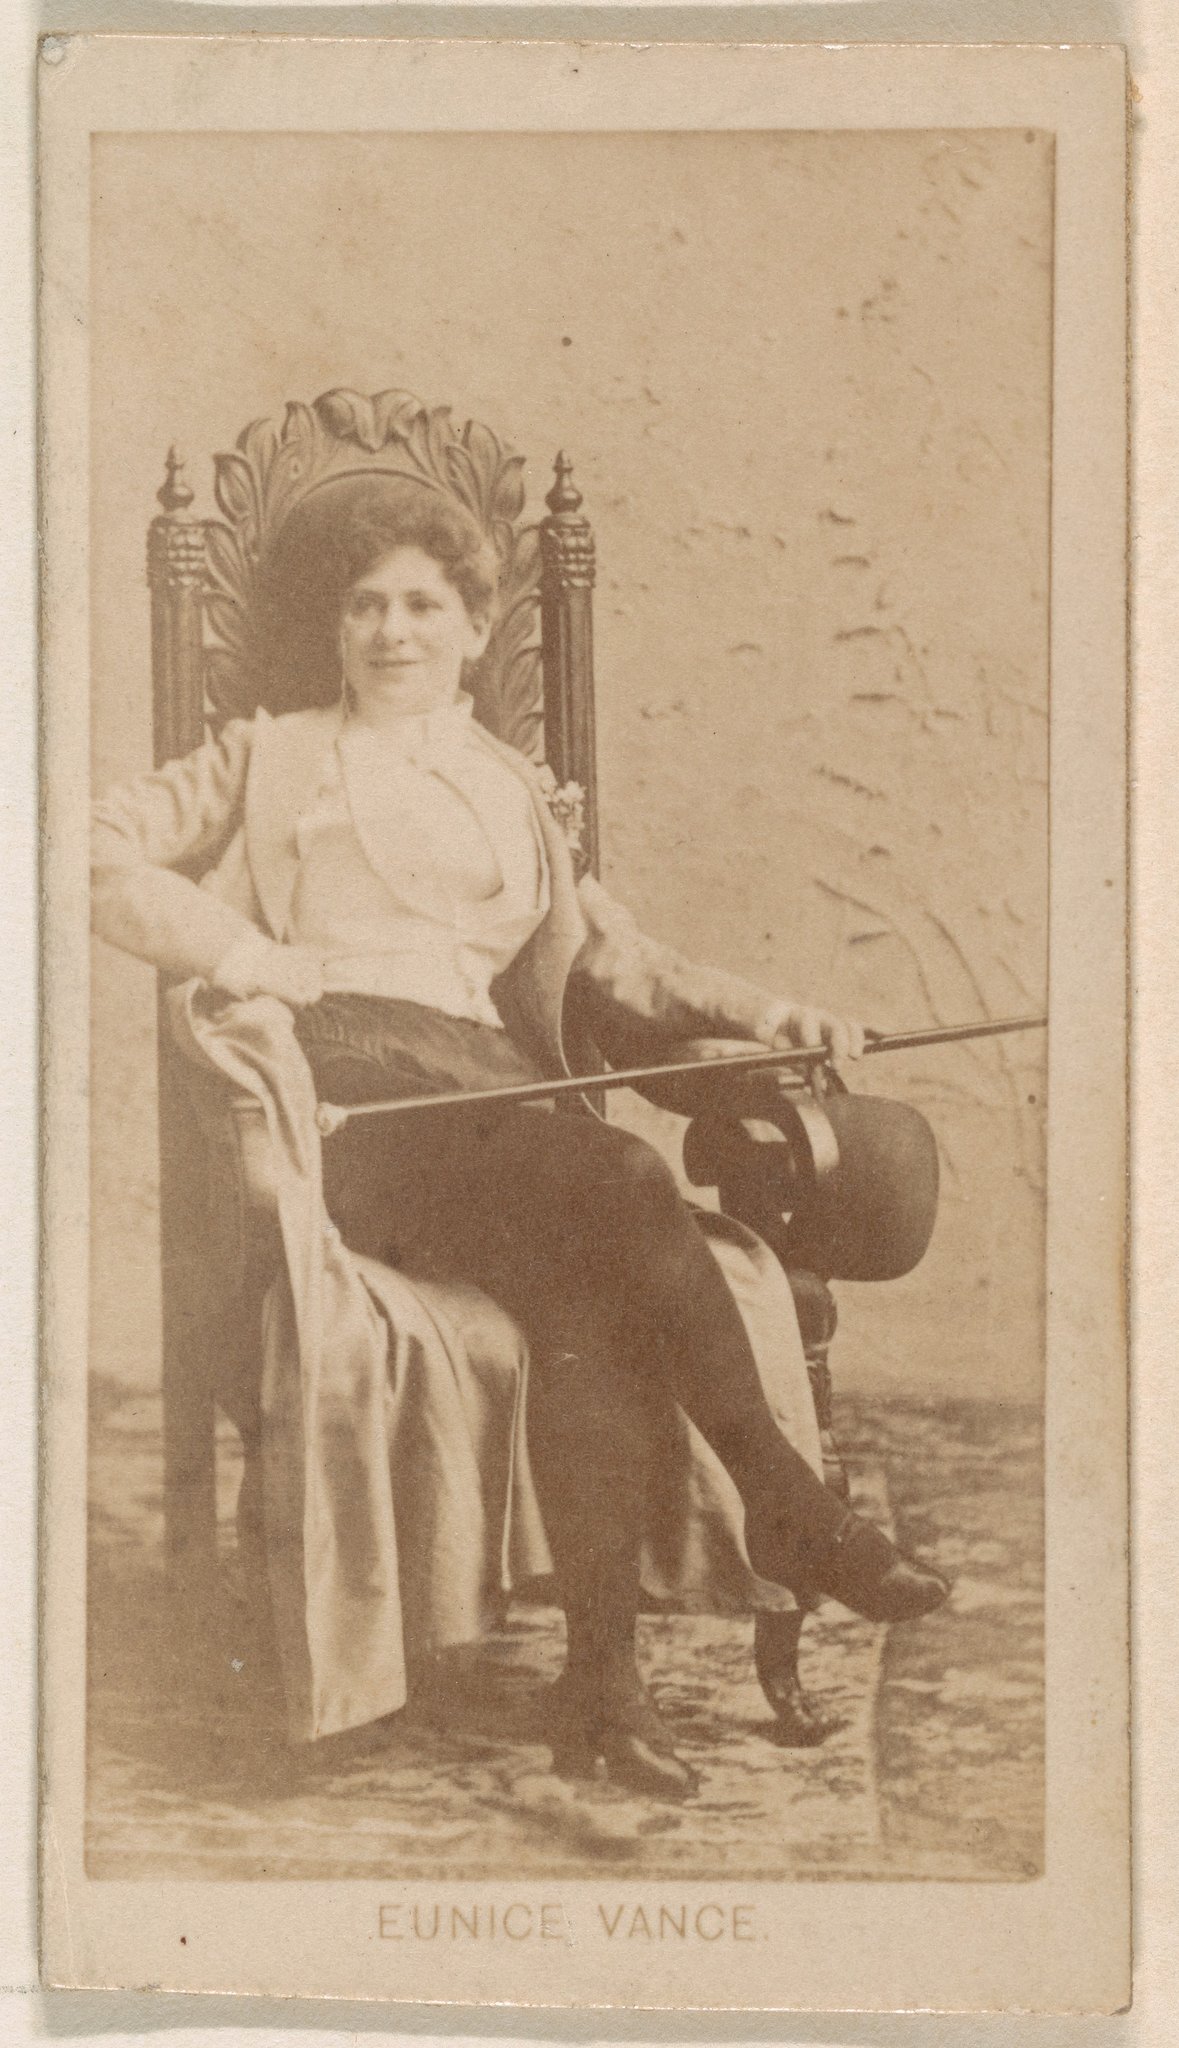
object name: photograph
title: Miss Eunice Vance, from the Actresses series (N245) issued by Kinney Brothers to promote Sweet Caporal Cigarettes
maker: kinney brothers tobacco company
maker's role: publisher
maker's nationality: american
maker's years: 1869-2011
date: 1890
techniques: albumen silver print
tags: portraits,women,actresses